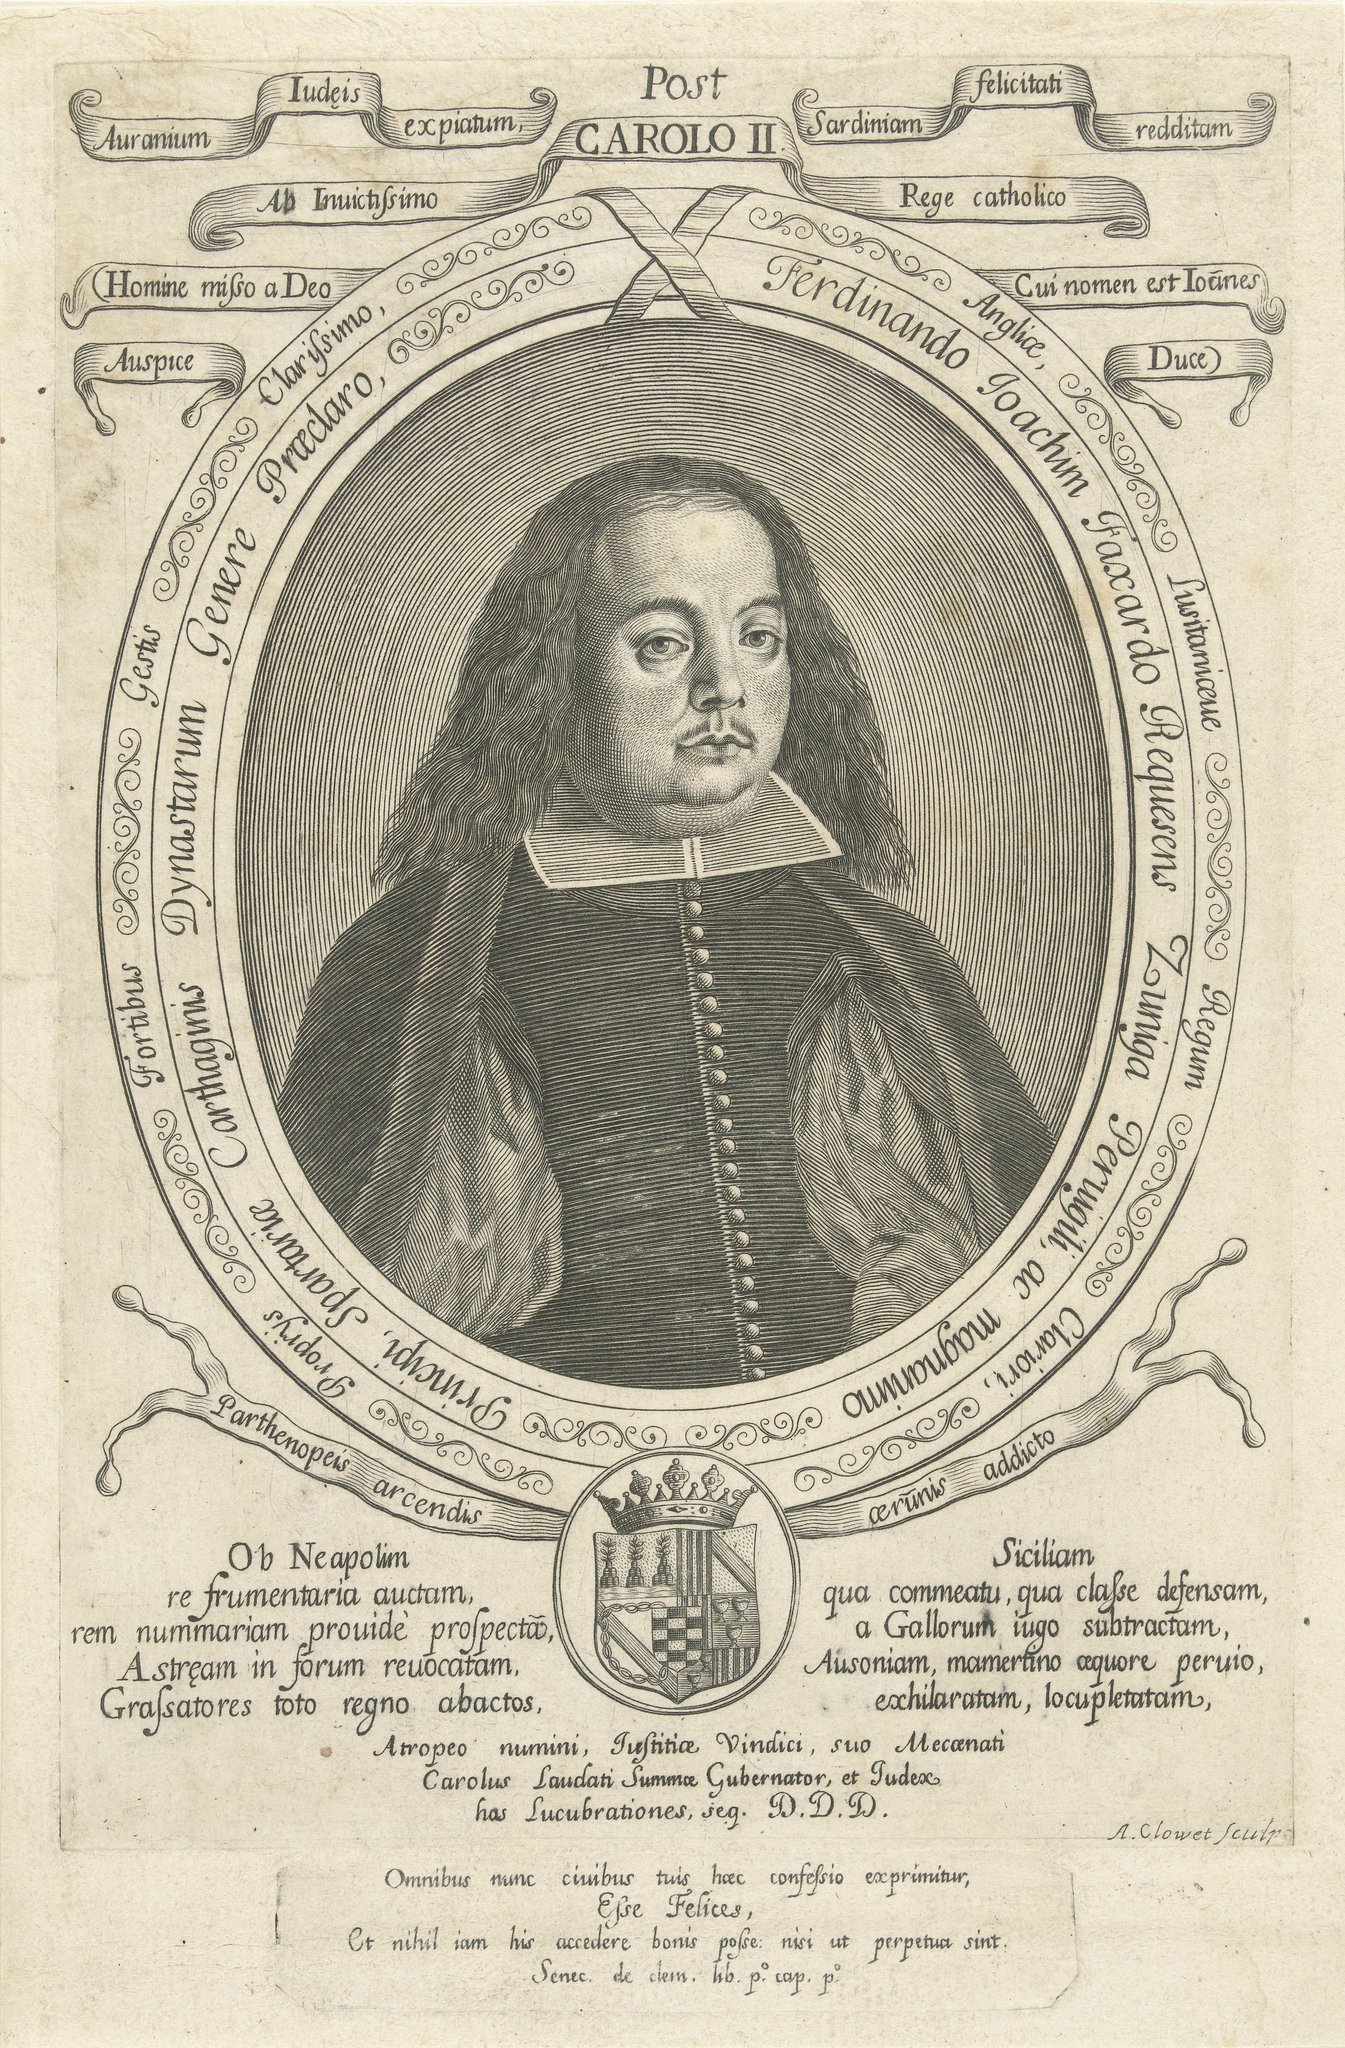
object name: print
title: Portret van Fernando Joaquín Fajardo-Zúñiga-Requesés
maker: albertus clouwet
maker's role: print maker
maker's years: 1636-1679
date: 1675-1679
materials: paper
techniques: engraving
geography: rome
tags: zaragoza, madrid, hertog, fernando joaquín fajardo-zúñiga-requesés y álvarez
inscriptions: collector's mark: Lugt 2228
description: Portret in ovale lijst van Fernando Joaquín Fajardo-Zúñiga-Requesés y Álvarez de Toledo, markies van Los Vélez en Molina en vanaf 1675 onderkoning van Napels (waarschijnlijk ook de aanleiding tot het maken van deze prent). Buste naar rechts. Boven het portret verschillende banderollen met Latijnse teksten. Onderaan de prent zijn wapenschild en een Latijns onderschrift.